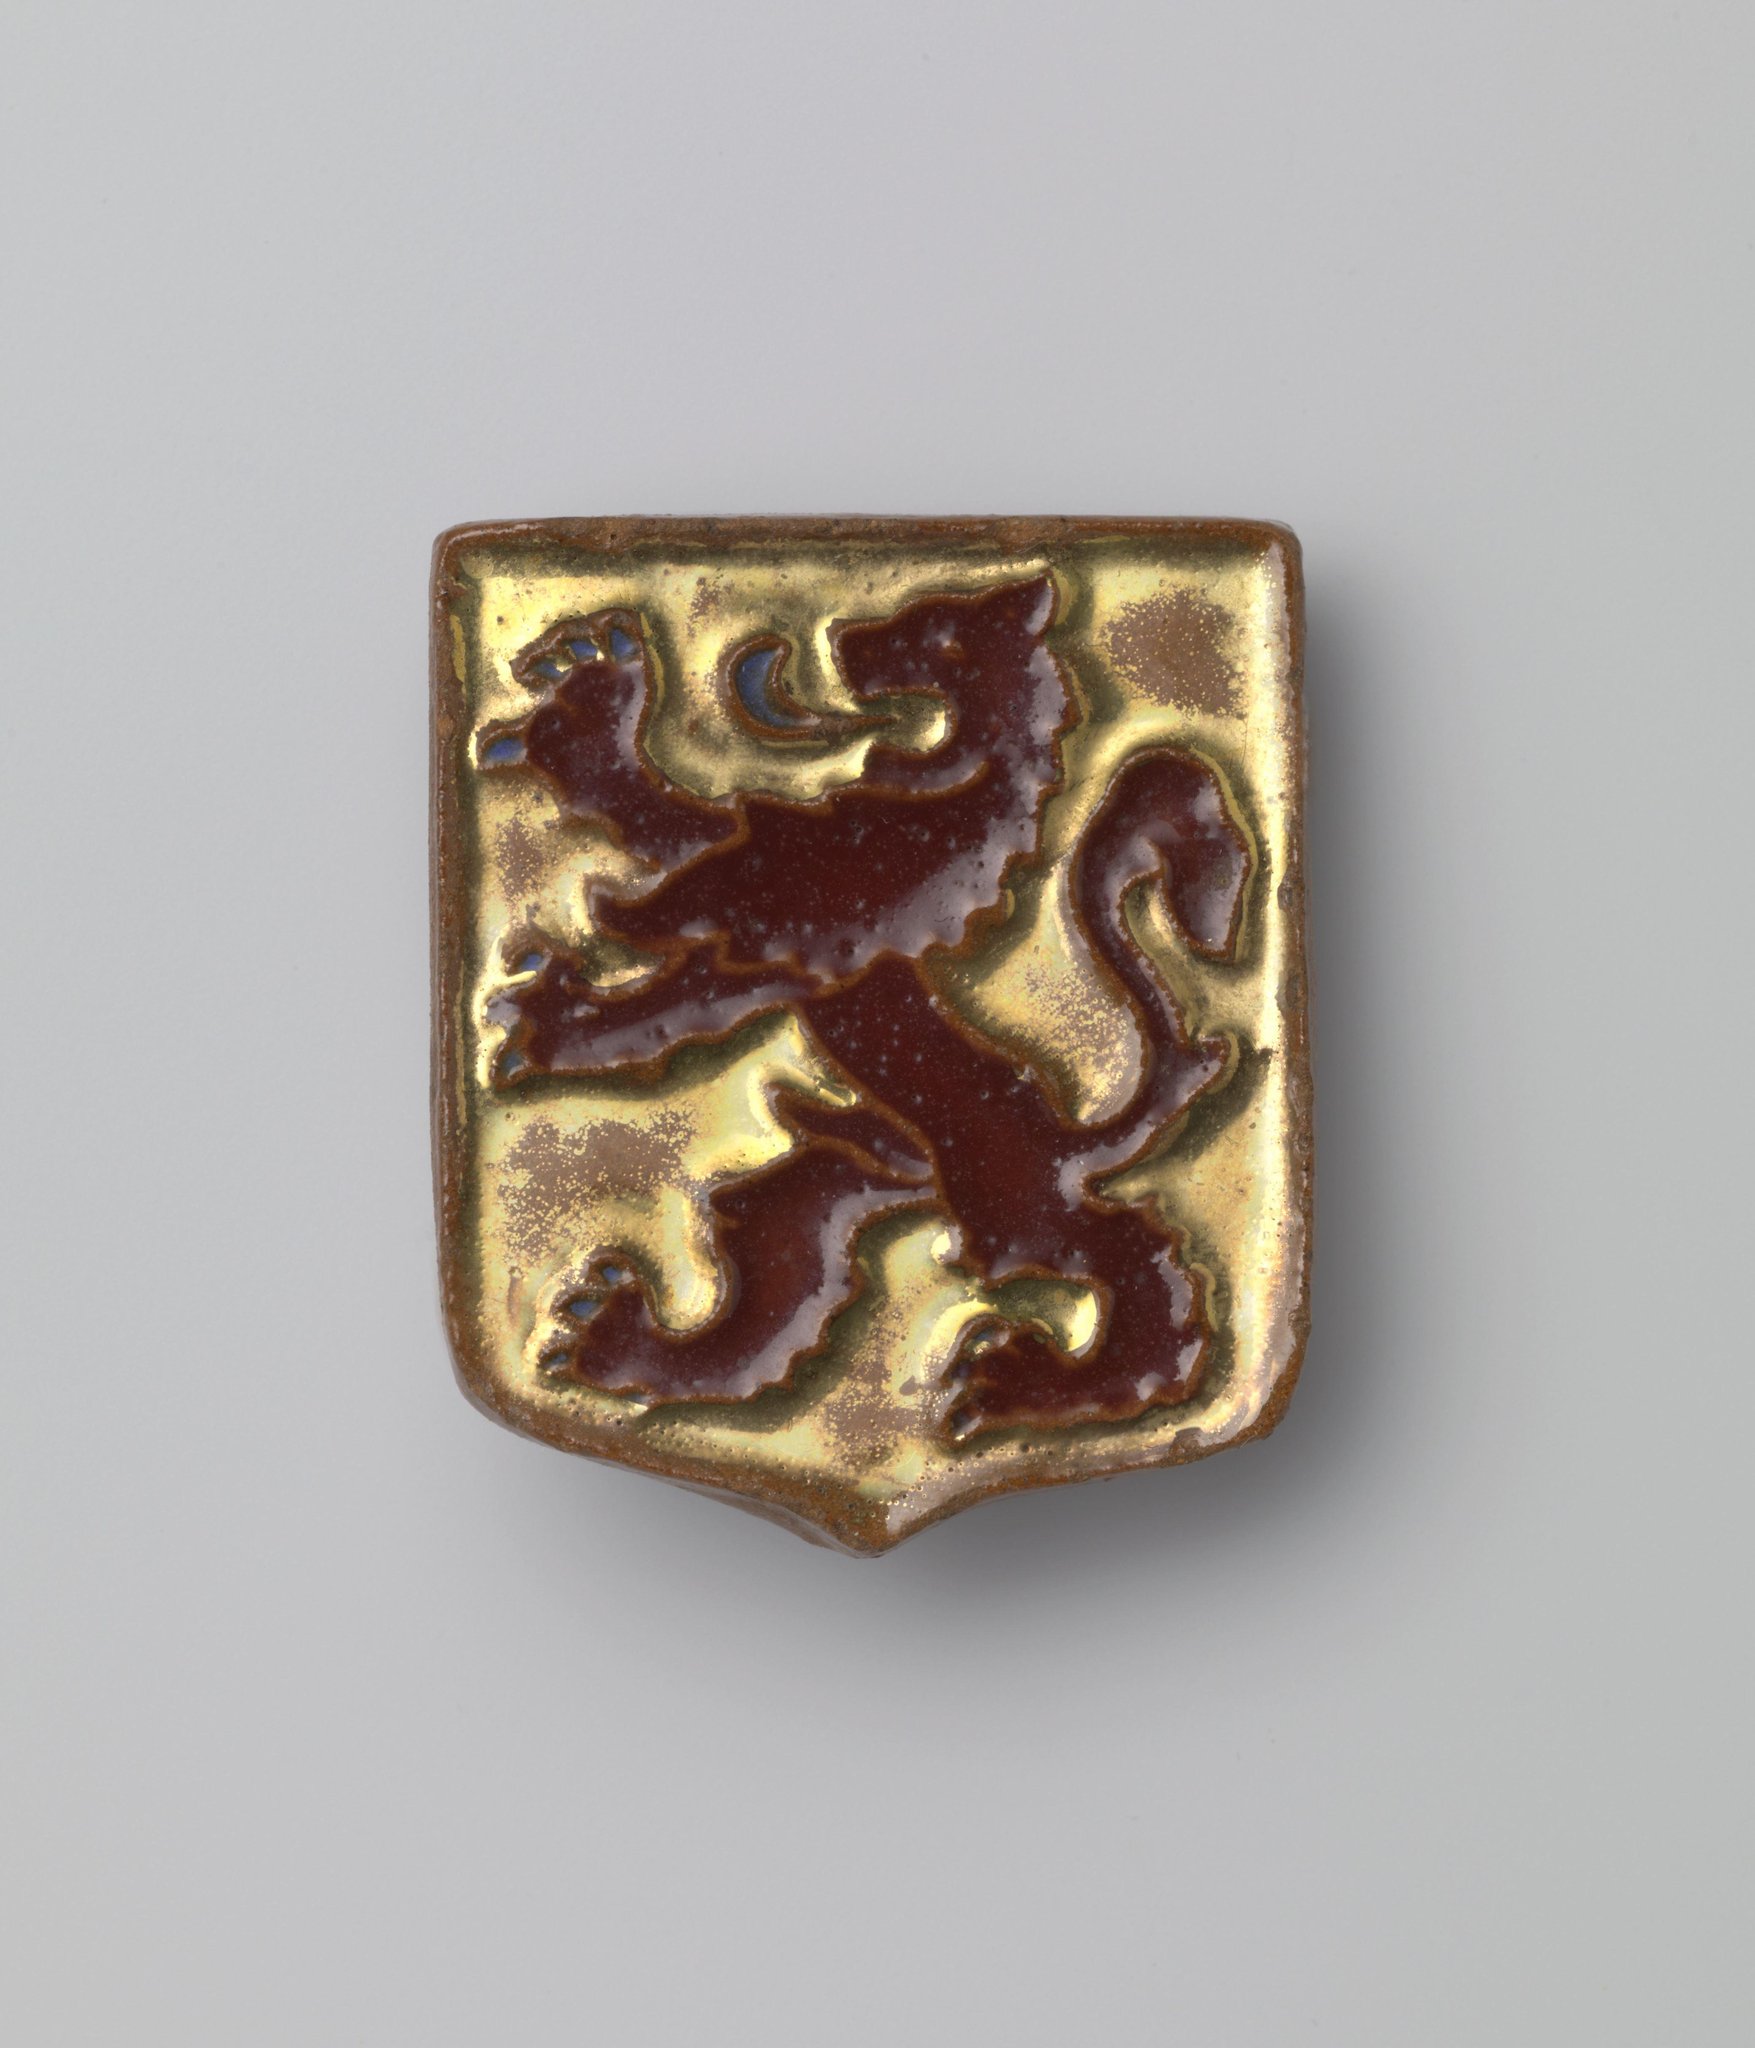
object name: brooch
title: Two ceramic brooches with the Dutch lion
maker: Anonymous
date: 1940-1950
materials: ceramic, metal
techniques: vitrification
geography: tegelen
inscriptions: : ‘TEGELSCHE KERAMIEK HANDWERK’, : ‘2.50’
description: Silent Resistance –War and Liberation Jewellery During the Second World War, small pieces of jewellery were worn in the Netherlands as a silent protest against the German occupier. In April 1941, Dutch coins were officially confiscated for the war industry. As jewellery did not have to be surrendered, coins were quickly transformed into rings, brooches, pins and bracelets. A portrait of Queen Wilhelmina was worn as a sign of resistance, as well as a token of loyalty to the royal family. Margriet Francisca, the third daughter of Princess Juliana and Prince Bernard, was born in Canada in January 1943. The pin with the three yellow chicks refers to the three young princesses Beatrix, Irene and Margriet and the steadfastness of the Dutch royal family. After the liberation, coins and silver were used for jewellery conveying messages of hope for a peaceful future.